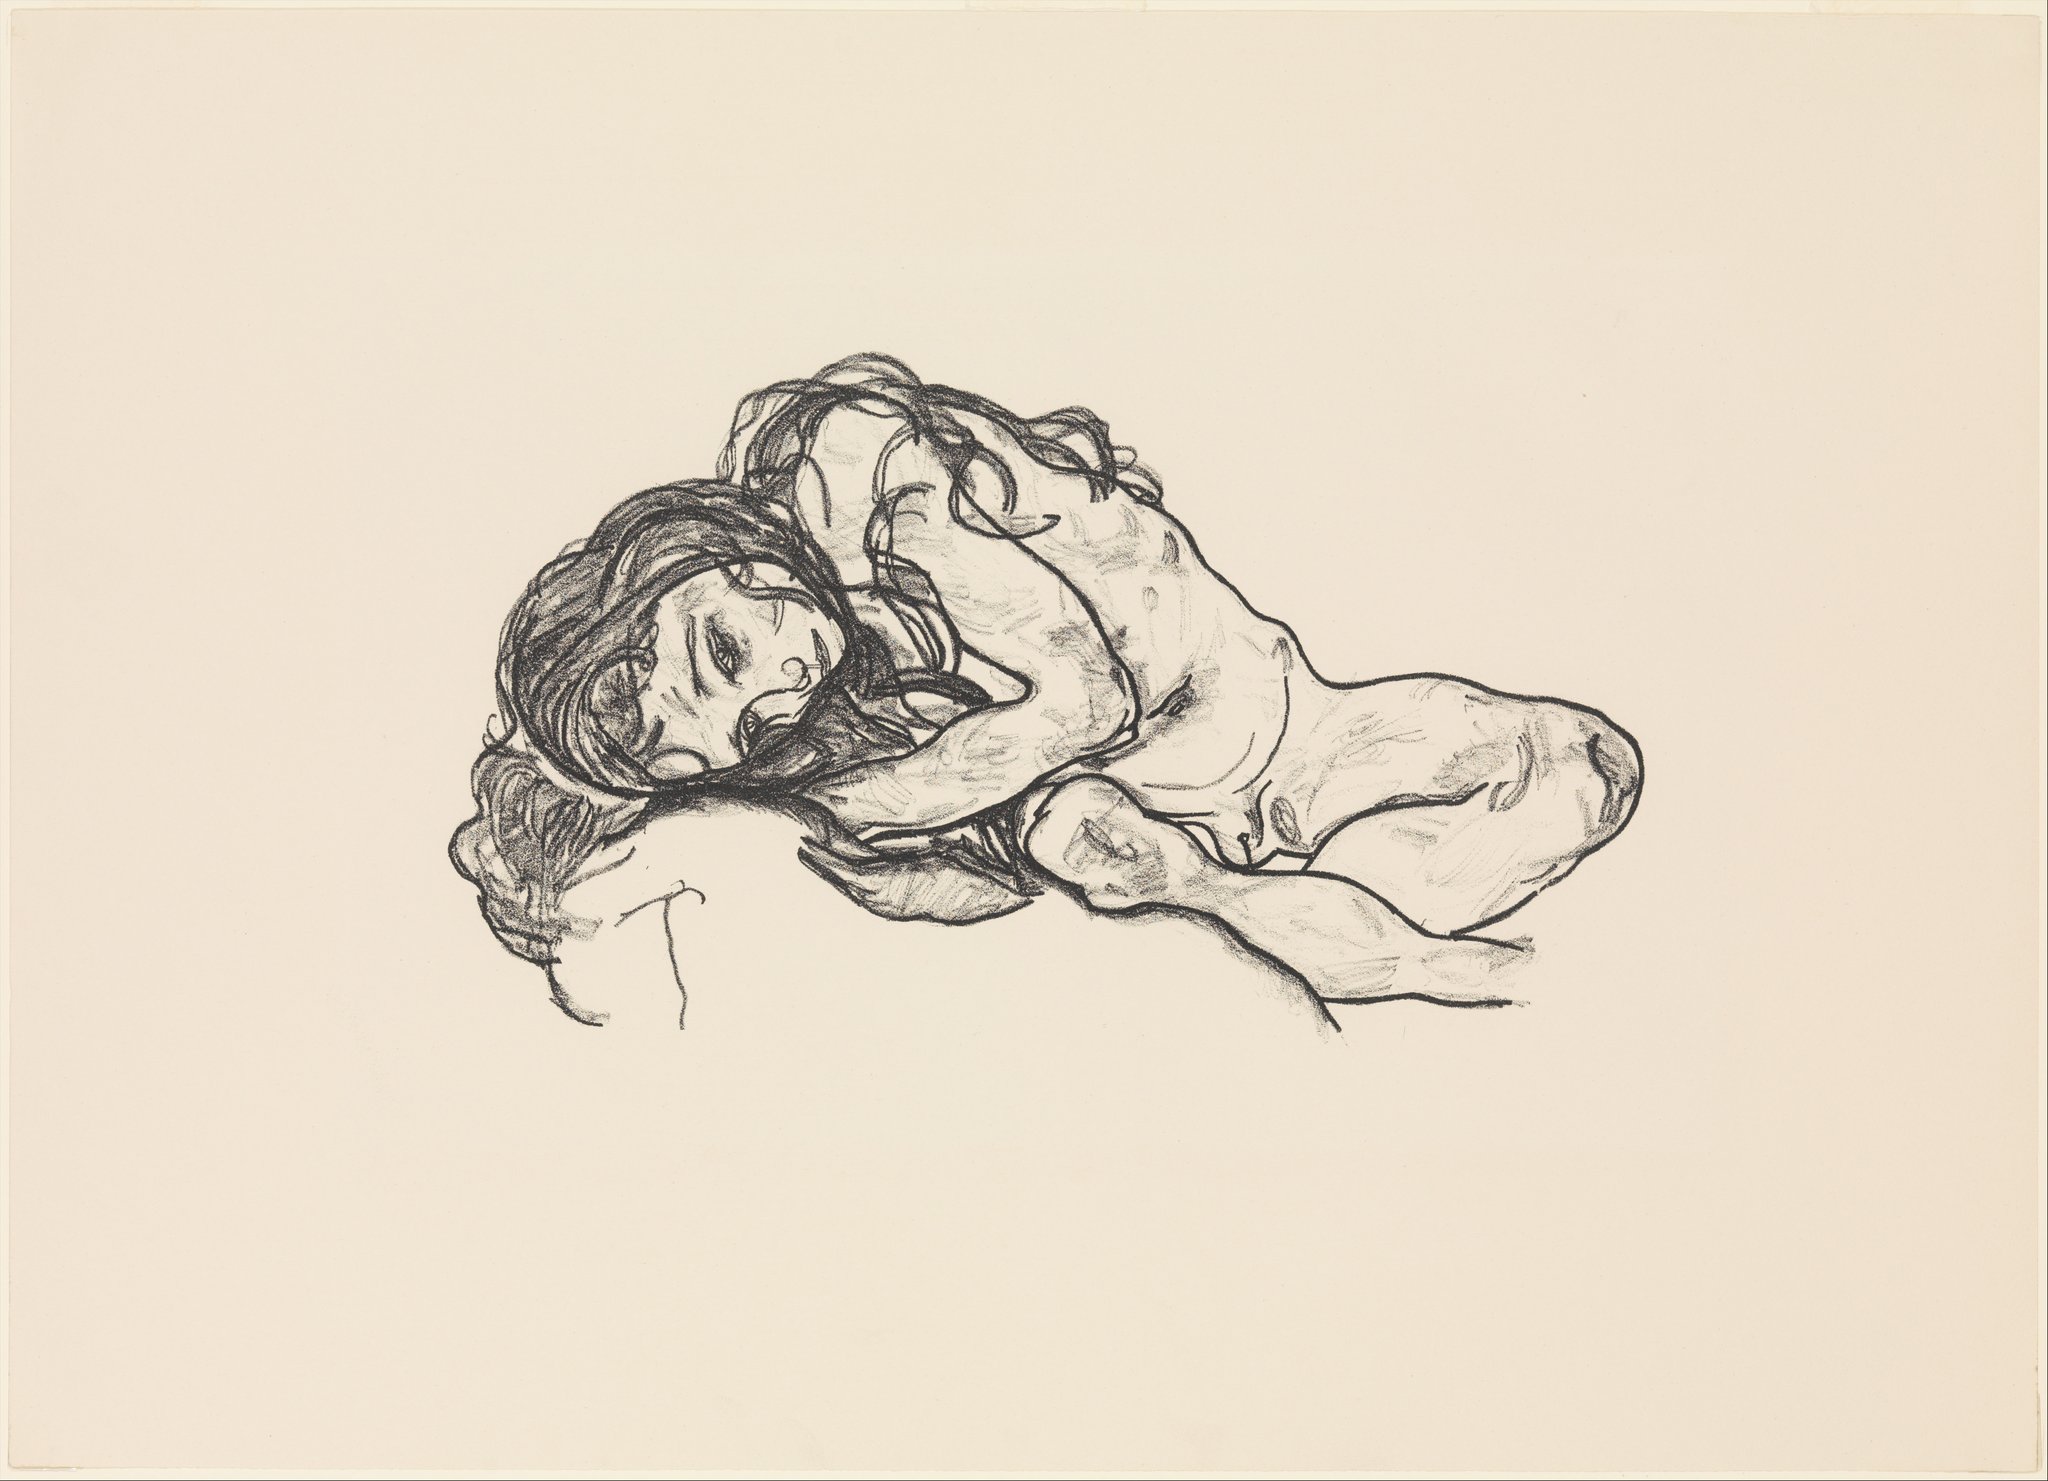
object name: print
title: Girl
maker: egon schiele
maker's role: artist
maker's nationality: austrian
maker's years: 1890-1918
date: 1918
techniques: lithograph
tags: female nudes